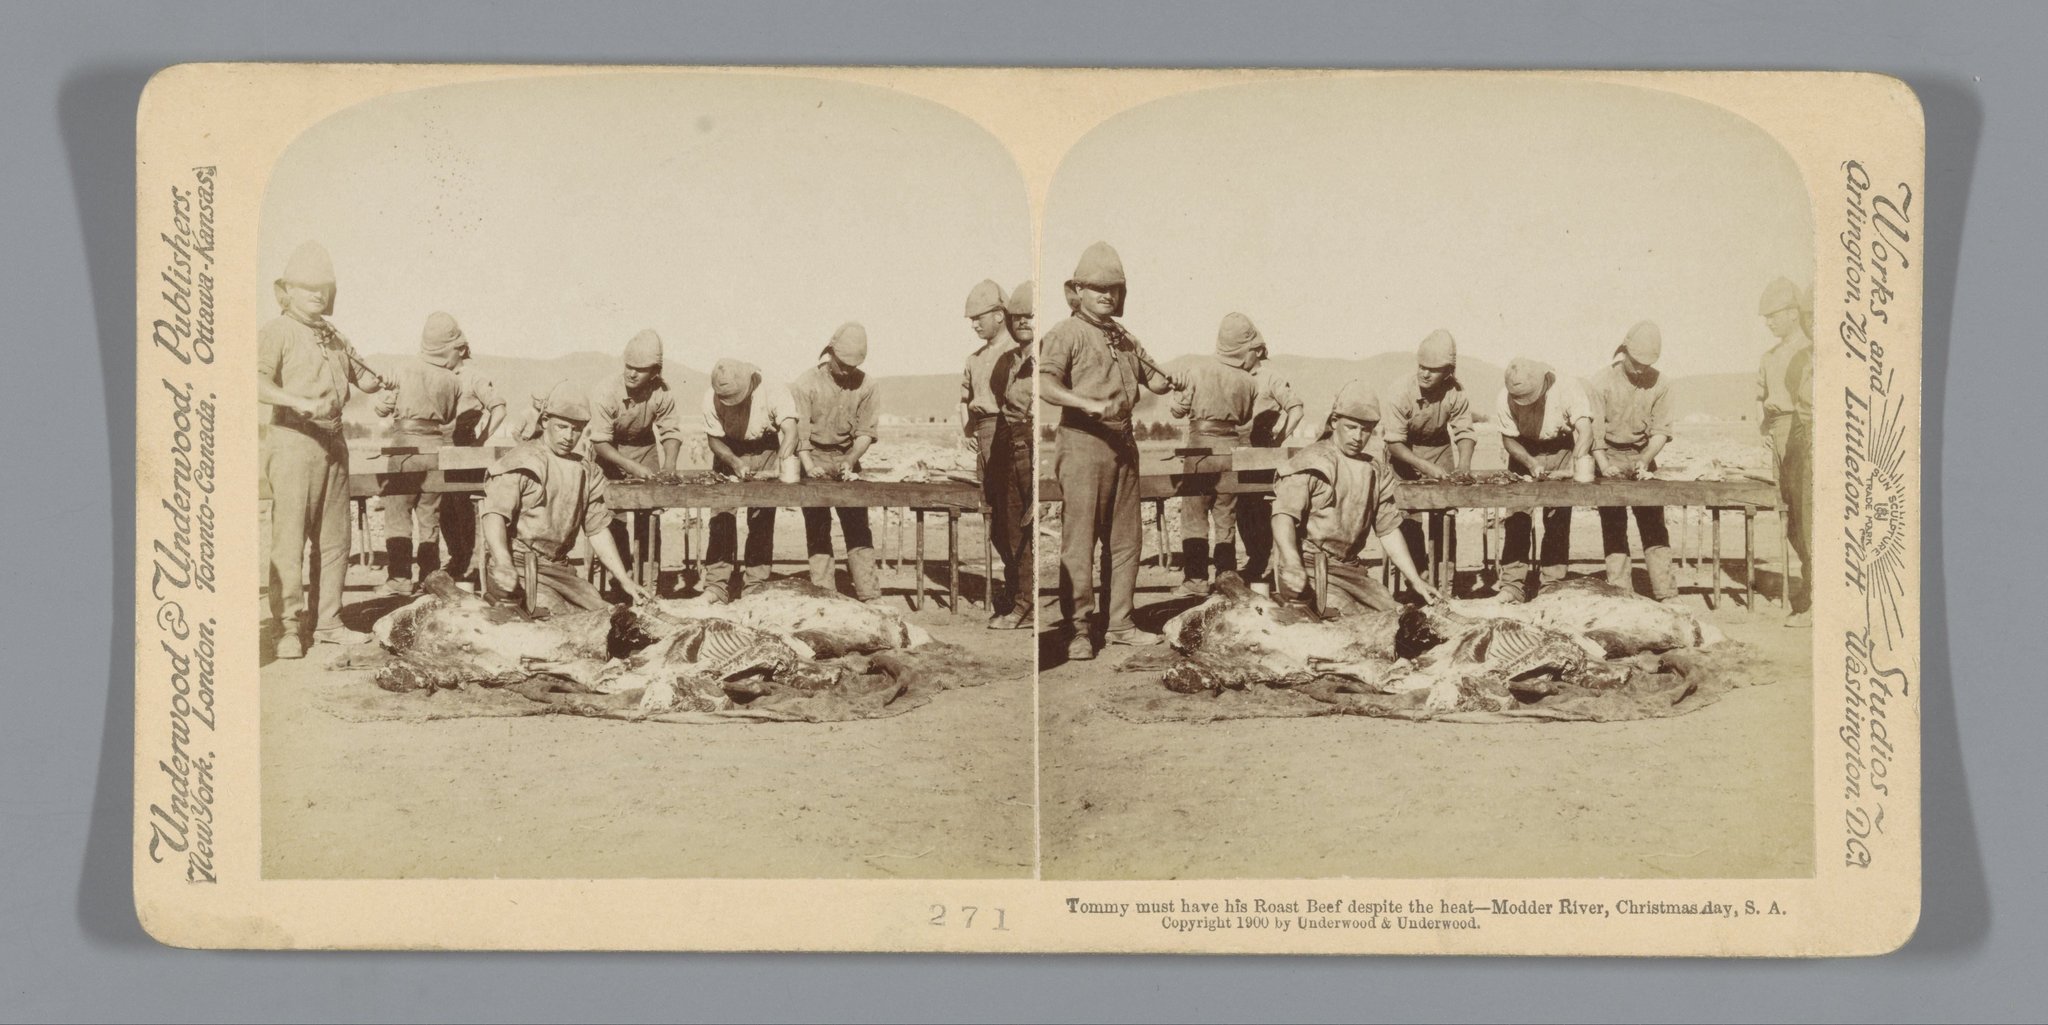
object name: stereograph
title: Britse soldaten bereiden rosbief op kerstdag, Modderrivier, Zuid-Afrika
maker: Anonymous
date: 1900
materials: cardboard, paper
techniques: albumen print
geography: modderrivier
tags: kinds of meat (with name), preperation of food ~ military service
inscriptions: inscription: ‘Works and Studios ~/ Arlington, N.J. Littleton, N.H. Washington, D.C.’, inscription, number: ‘271’, copyright notice: ‘Copyright 1900 by Underwood & Underwood.’